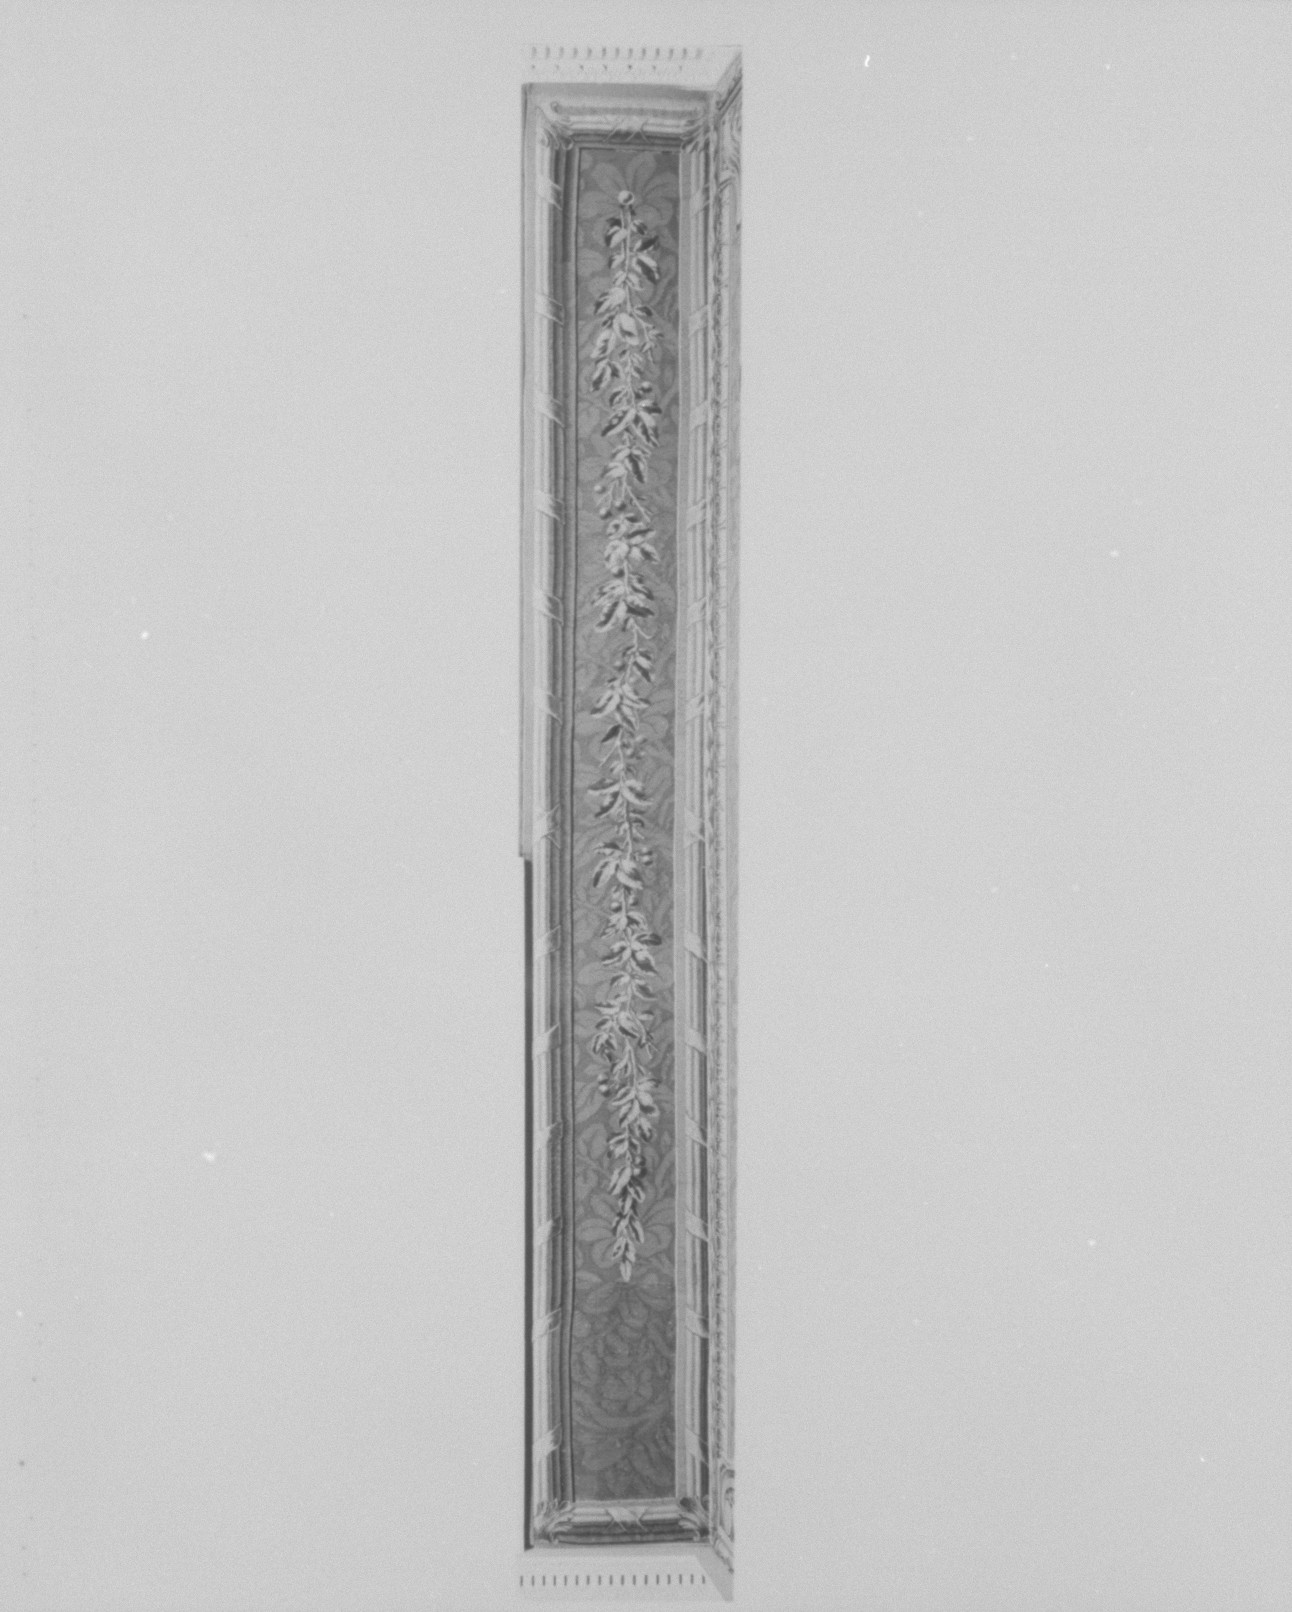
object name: tapestry panel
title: Vertical Panels with Cherry Spray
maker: jacques germain soufflot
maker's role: designer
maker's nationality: french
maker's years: 1713-1780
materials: silk, wool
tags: leaves